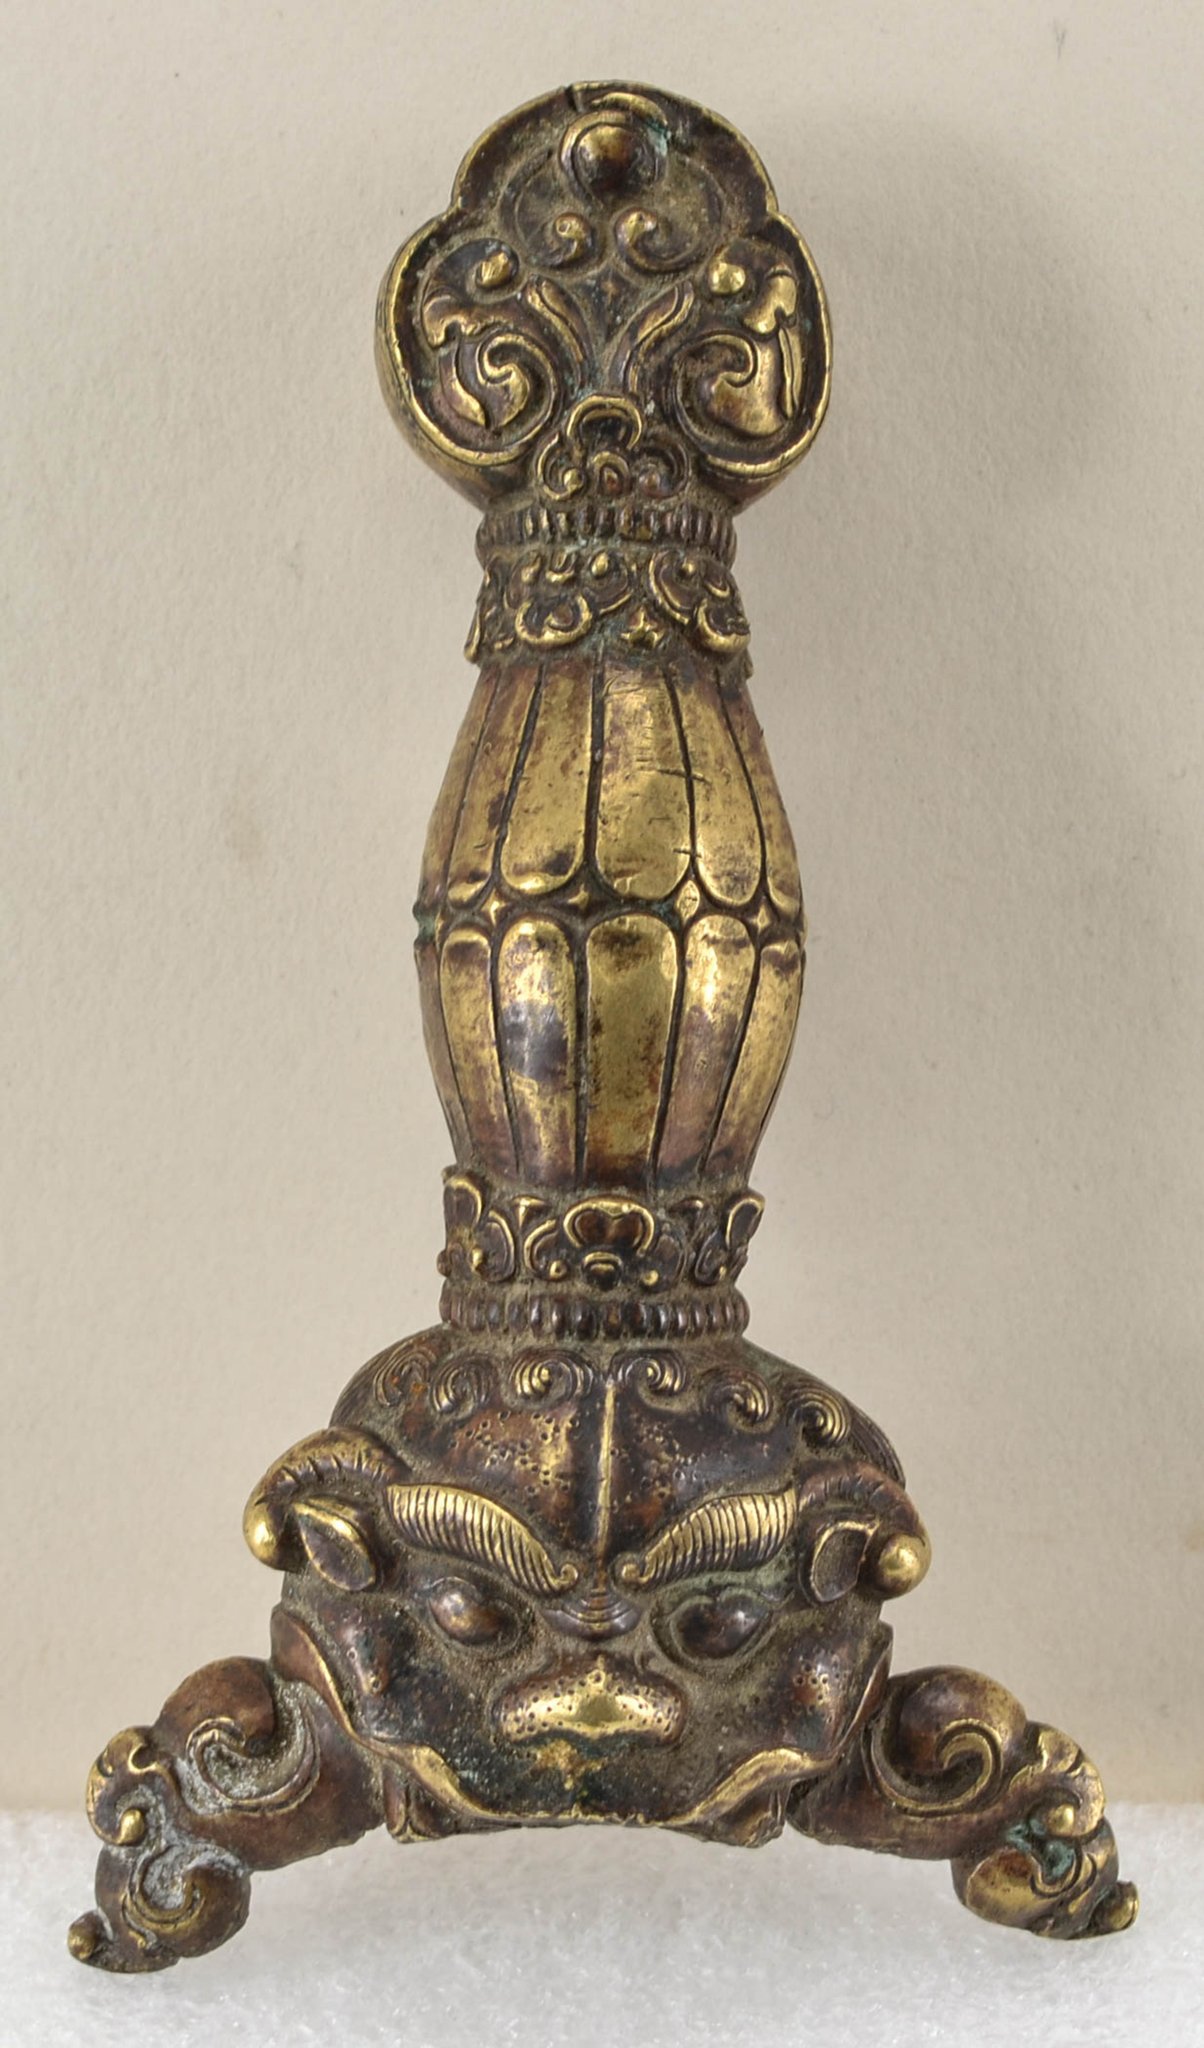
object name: hilt of a ritual sword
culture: tibetan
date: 1501-1700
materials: copper alloy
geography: tibet